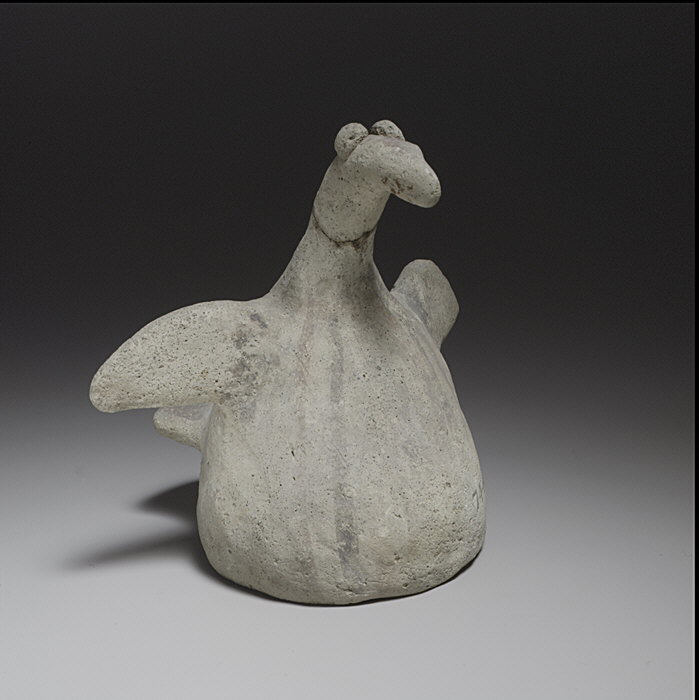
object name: bell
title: Terracotta bird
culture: cypriot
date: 600-480 BCE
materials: terracotta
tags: birds